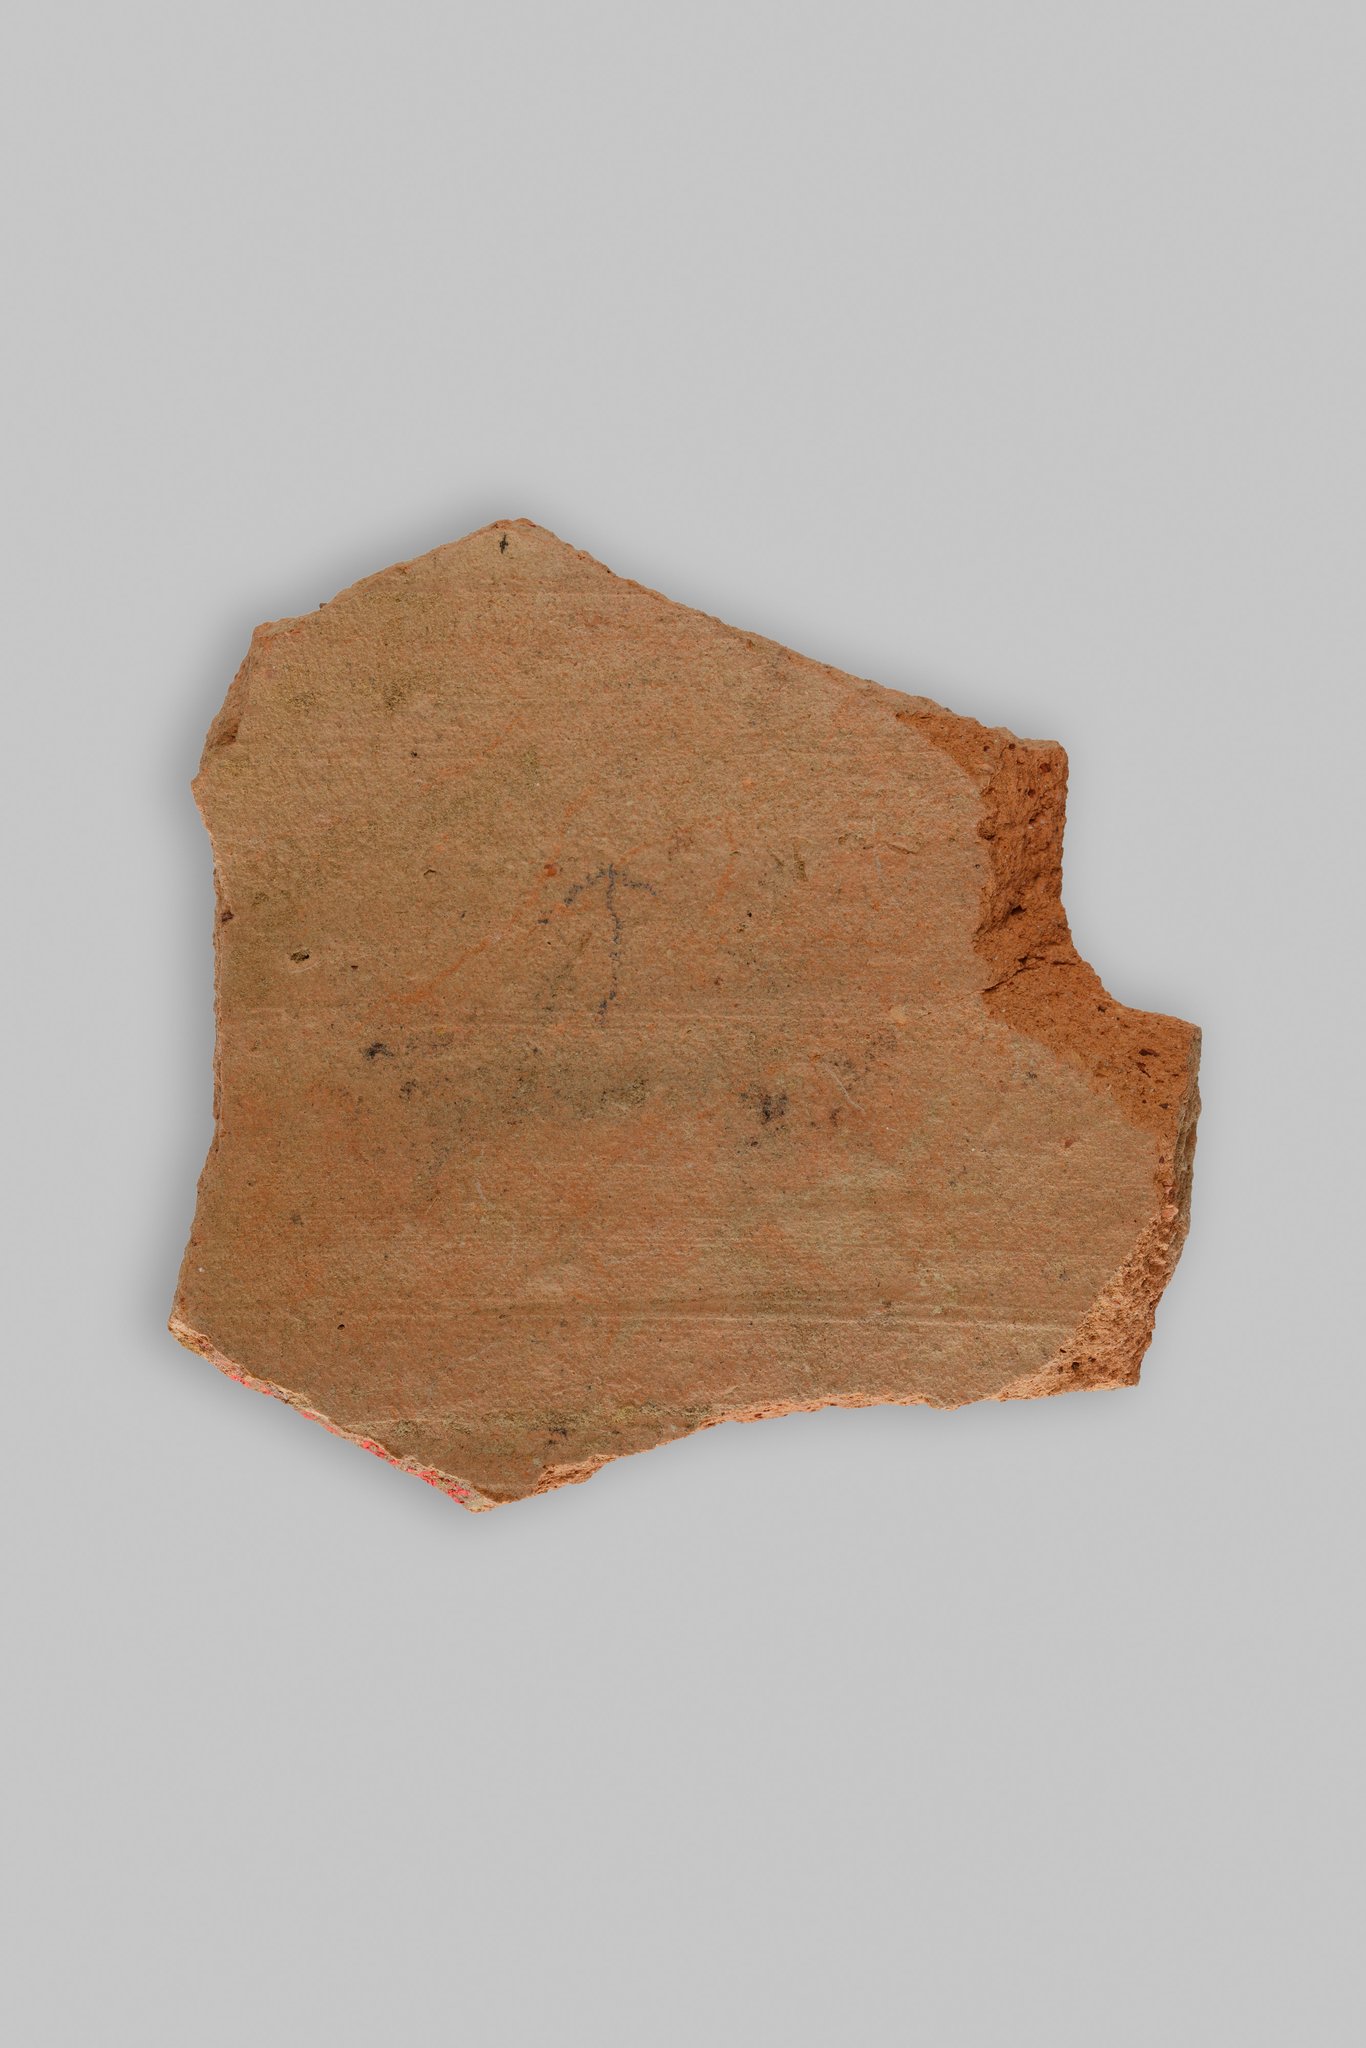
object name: ostracon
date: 400-30 BCE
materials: ink, pottery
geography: egypt